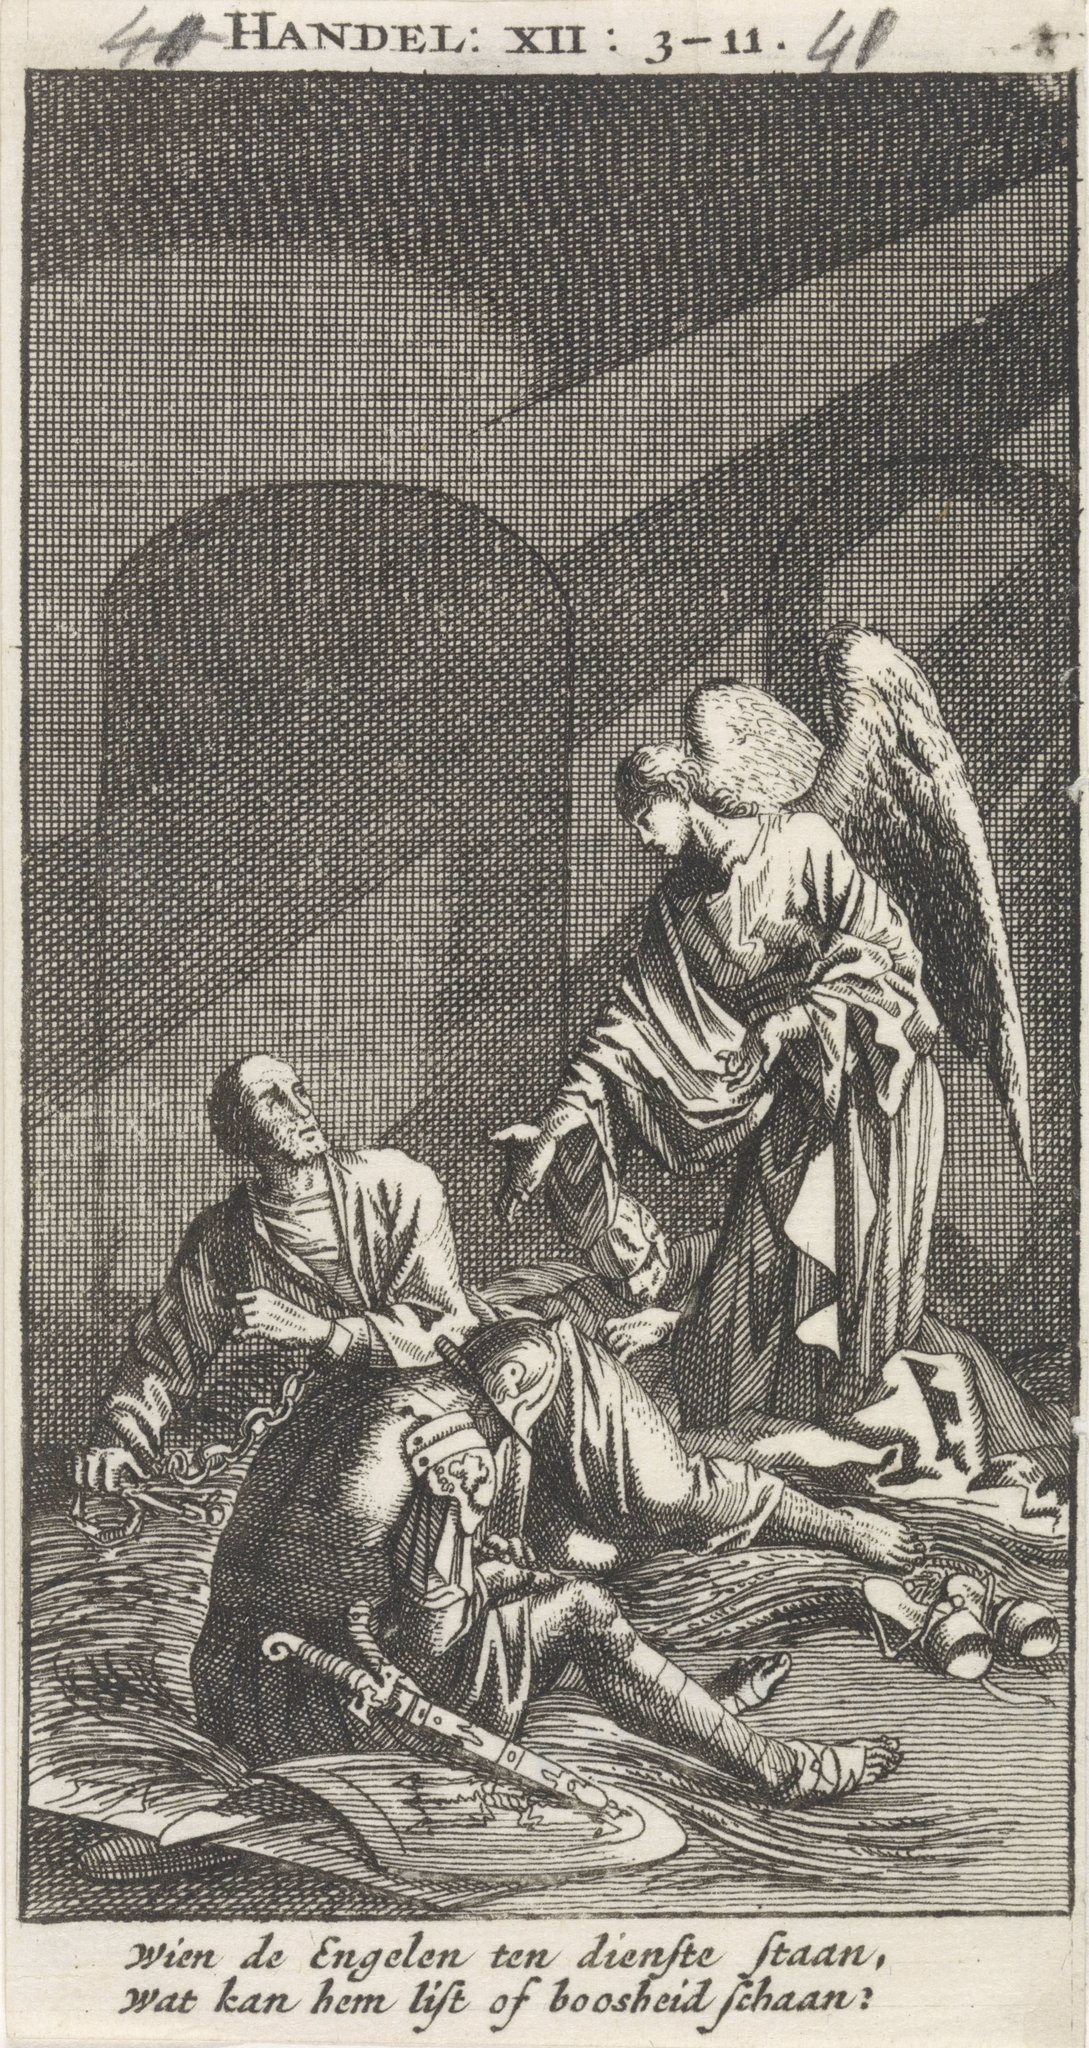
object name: print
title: Bevrijding van Petrus uit de gevangenis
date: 1712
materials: paper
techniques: etching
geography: amsterdam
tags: the angel leads peter past the sleeping guards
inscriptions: collector's mark: Lugt 2228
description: Kopie van illustratie voor: Luyken, Jan. Bybel printen. Amsterdam: Pieter Arentsz. II (wed.) en Cornelis van der Sys, 1712, p. 40.